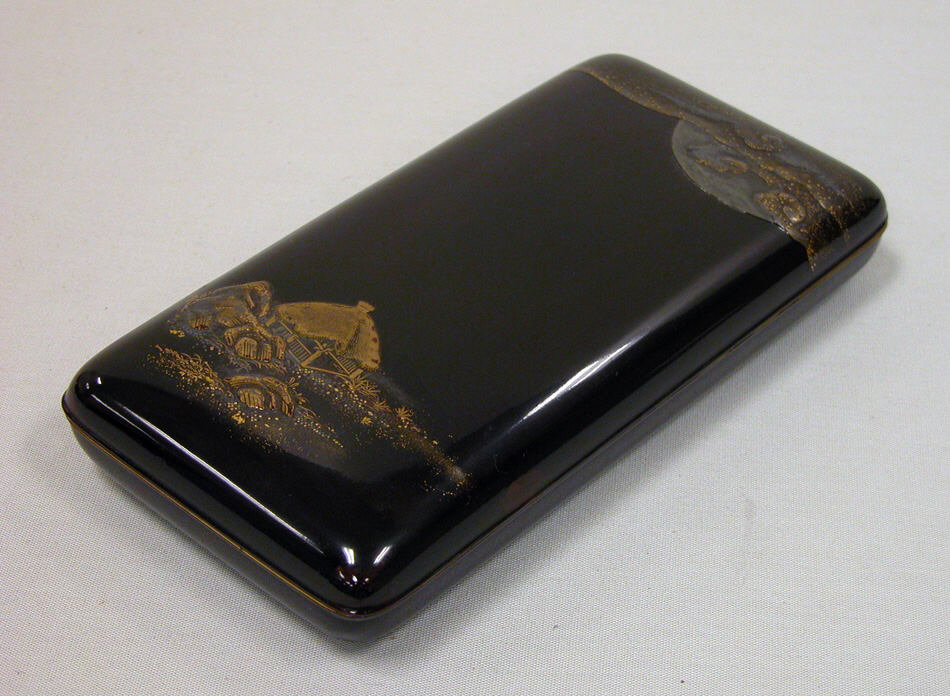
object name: writing box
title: Writing Box with Design of Rustic Shelter and Clouds with Moon (cover), the Poet Saigyō Resting (inside)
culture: japanese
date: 1701-1800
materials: gold, lacquer, silver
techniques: maki